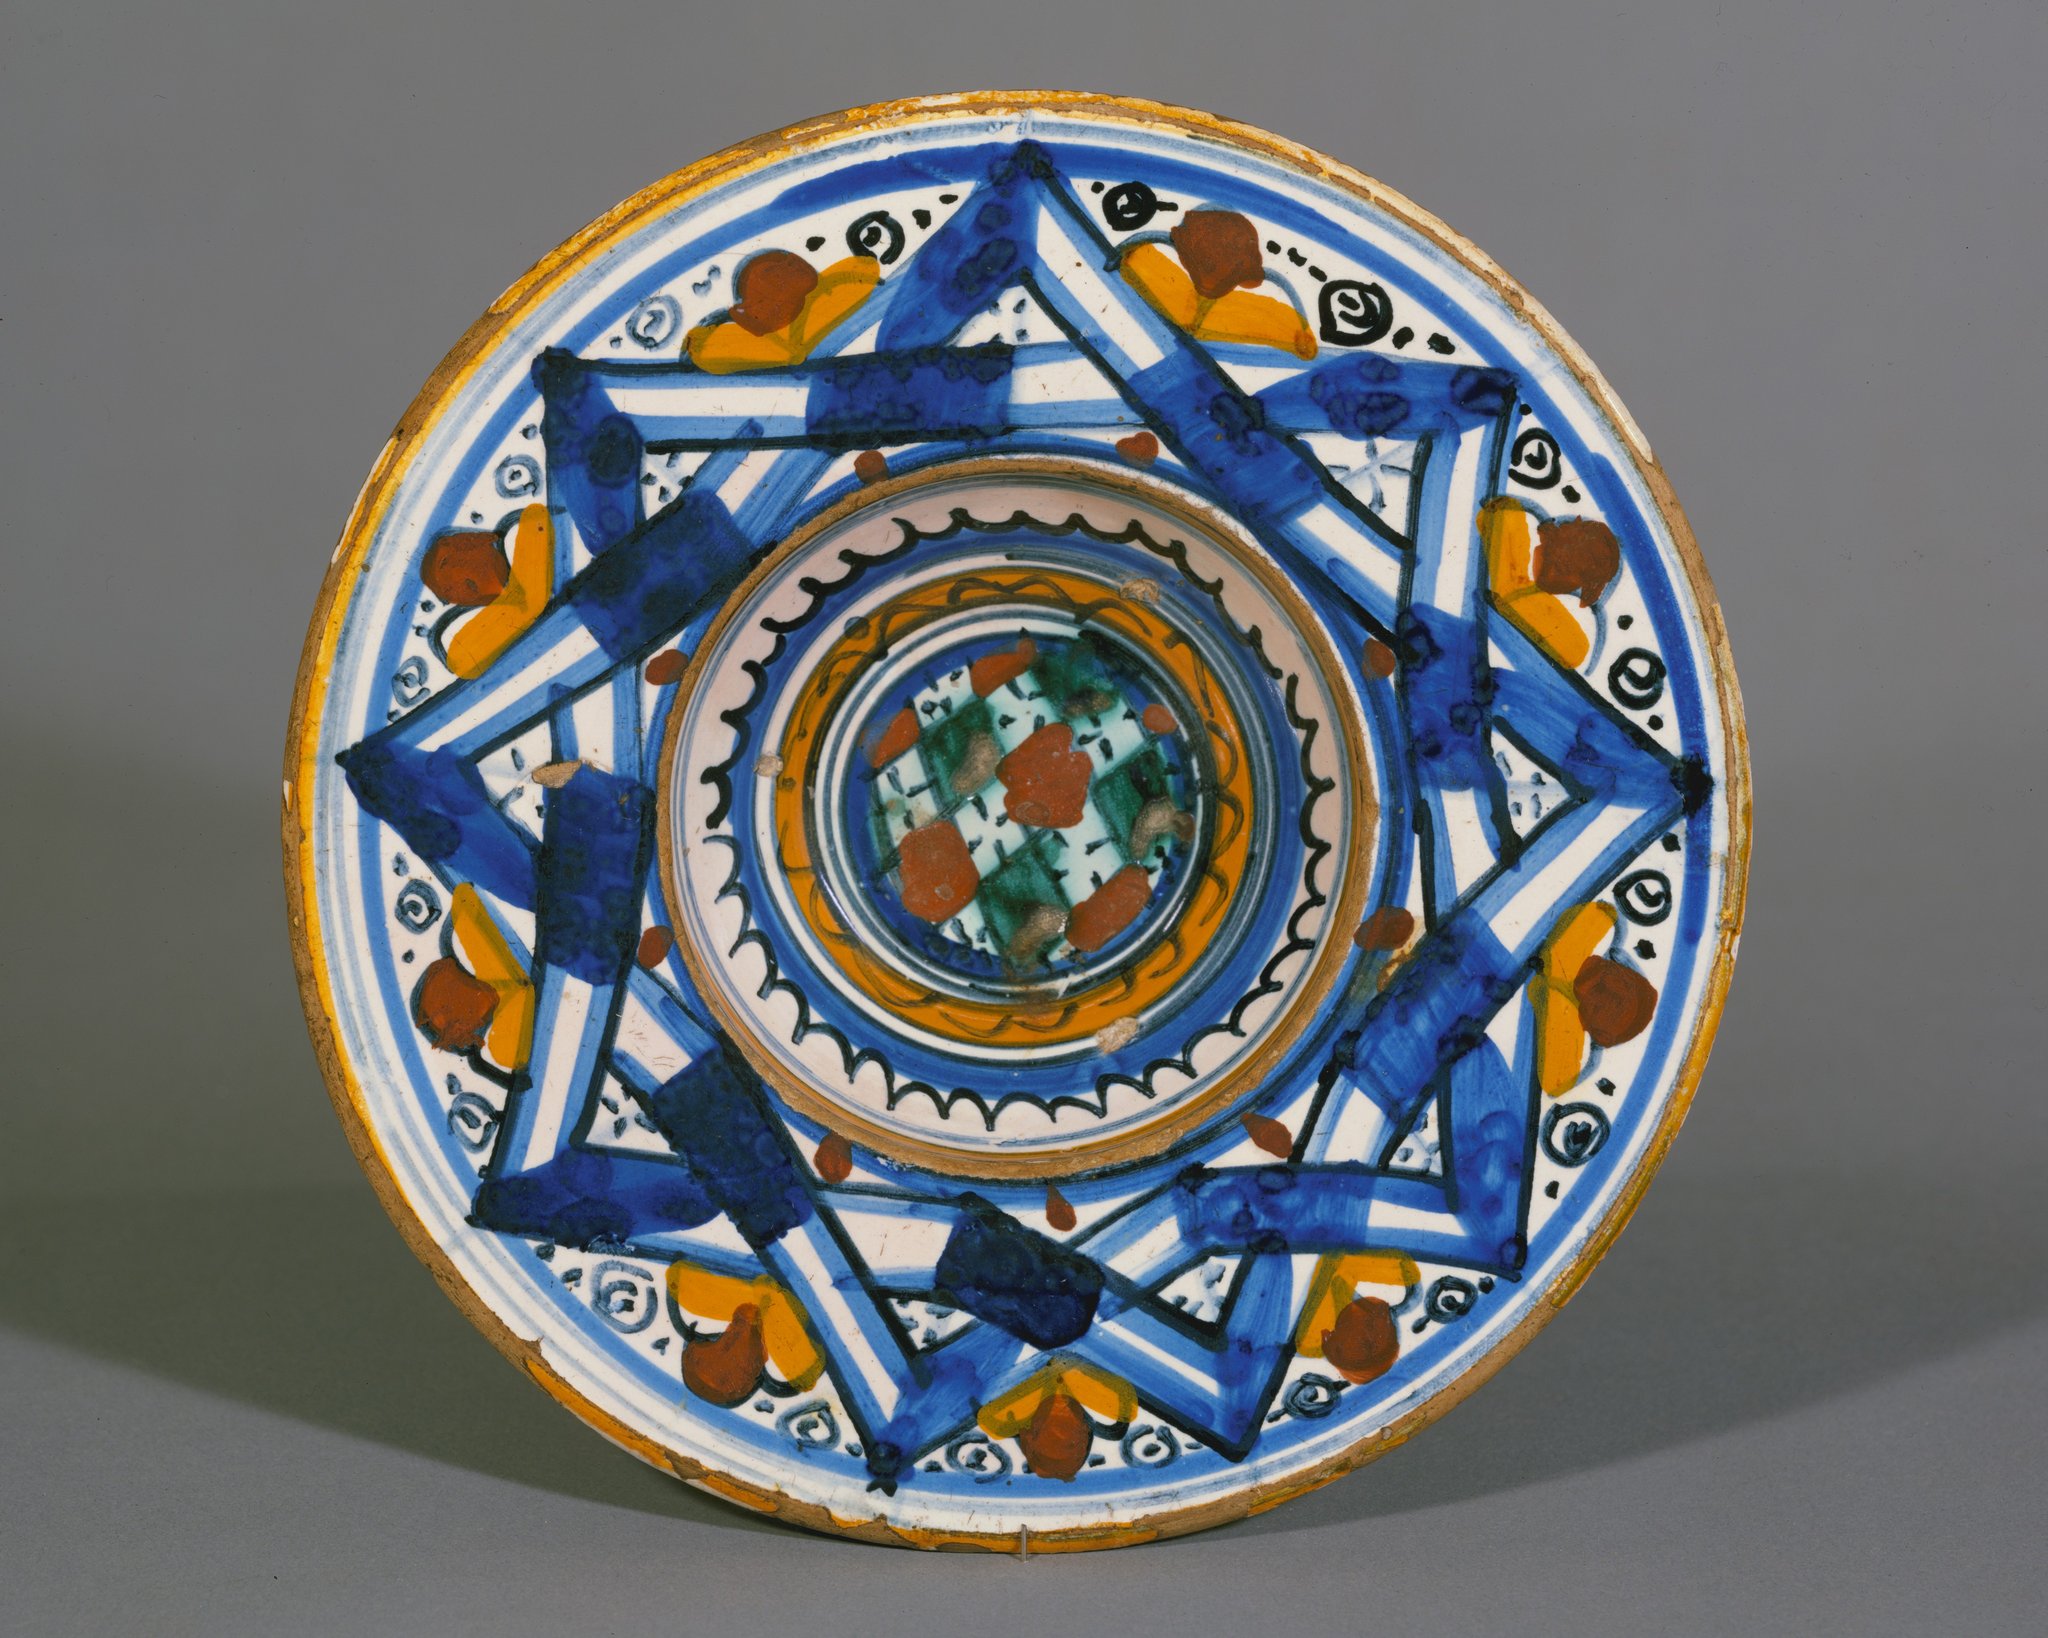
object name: plate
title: Plate (tondino)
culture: italian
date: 1480-1520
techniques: maiolica, glazing